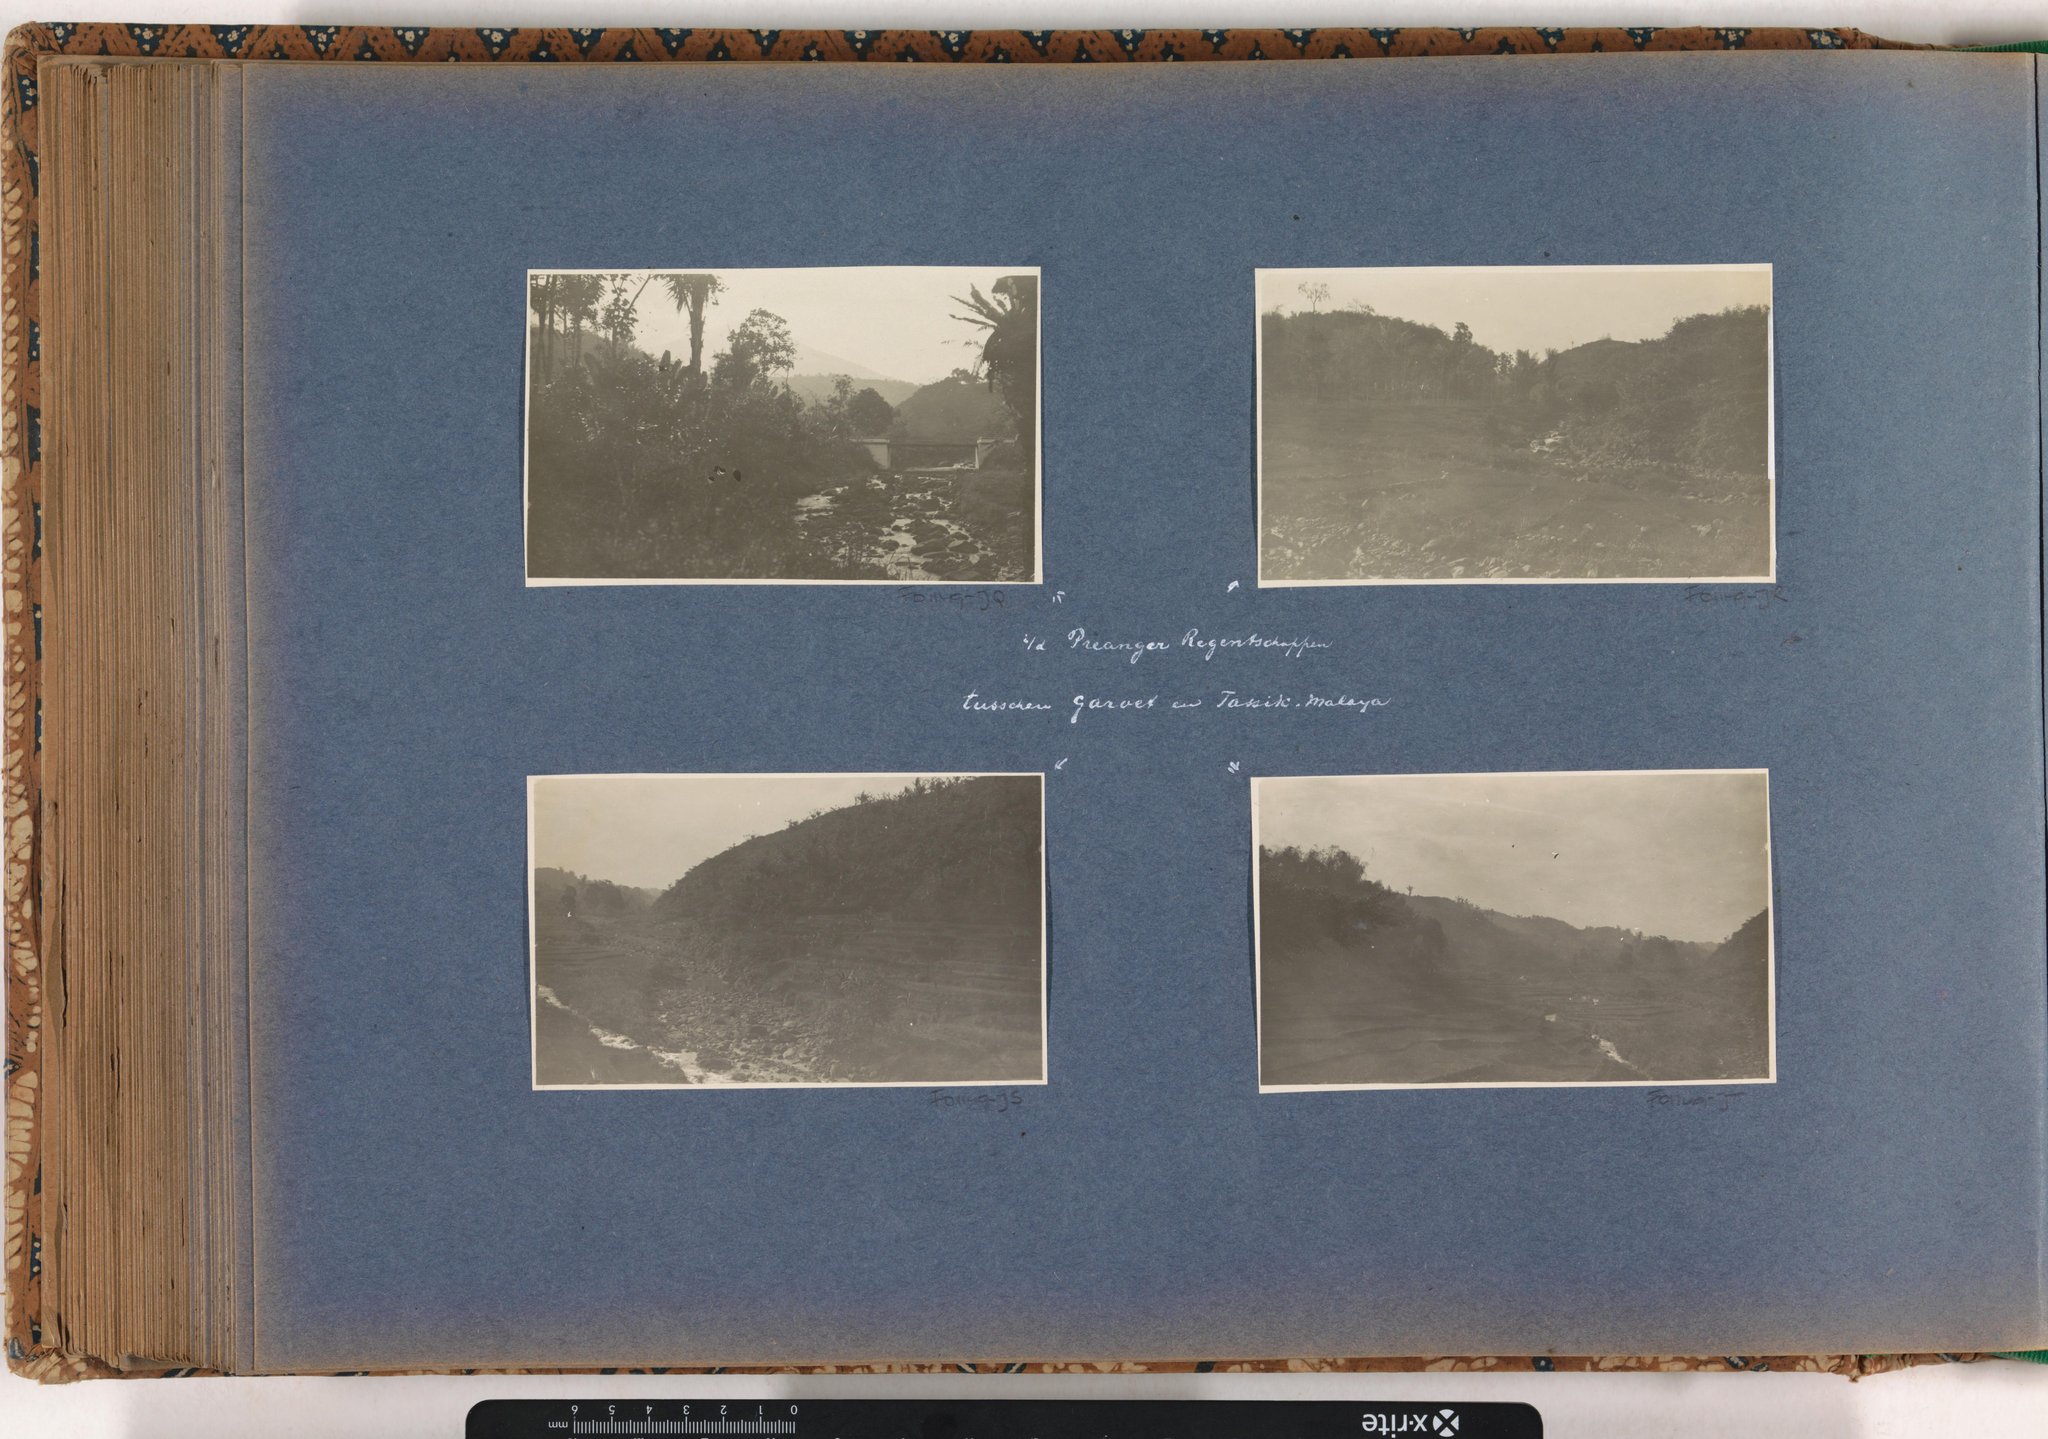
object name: photograph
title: Landschap tussen Garut en Tasikmalaya op Java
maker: Anonymous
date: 1900-1920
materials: paper, photographic support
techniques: gelatin silver print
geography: java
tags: landscapes in tropical and sub-tropical regions, java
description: Onderdeel van reisalbum met foto's van bedrijvigheid en bezienswaardigheden op Sumatra en Java en van de reis naar en van Nederlands-Indië.